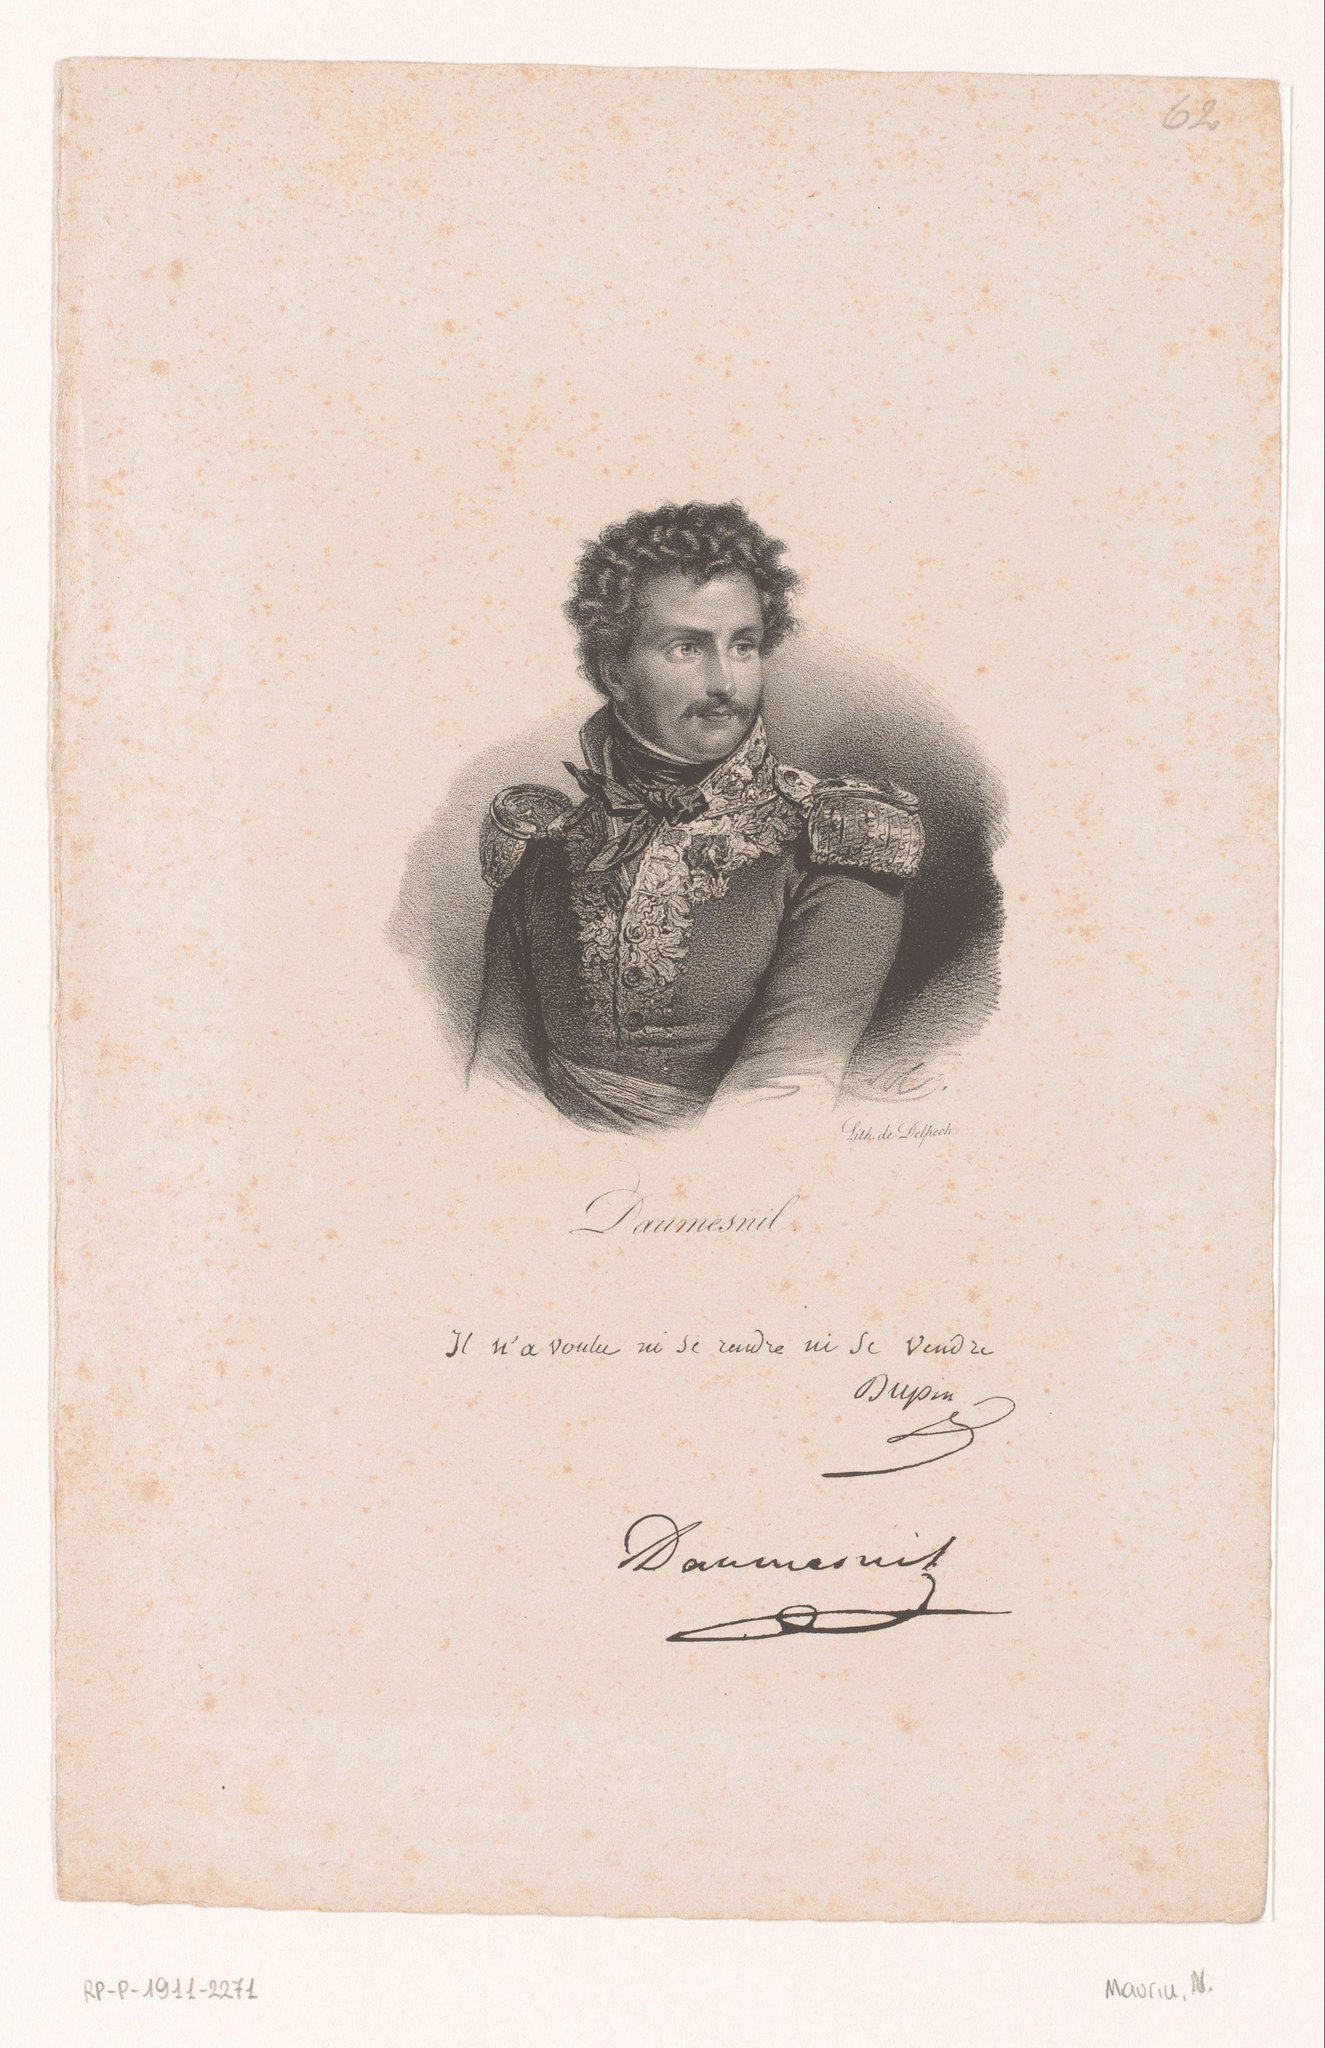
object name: print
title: Portret van Pierre Daumesnil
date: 1825-1842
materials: paper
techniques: lithograph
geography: paris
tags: historical persons, officer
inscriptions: collector's mark: Lugt 2228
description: Prent waarschijnlijk gebruikt voor: Iconographie des contemporains ou Portraits des personnes dont les noms se rattachent plus particulièrement, soit par leurs actions, soit par leurs écrits, aux divers événements qui ont eu lieu en France, depuis 1789, jusqu'en 1829 (…). Parijs: veuve Delpech, 1832-1833. Mogelijk komt de prent ook voor in eerdere en/of latere publicaties uitgegeven door veuve Delpech of haar opvolger Rosselin.